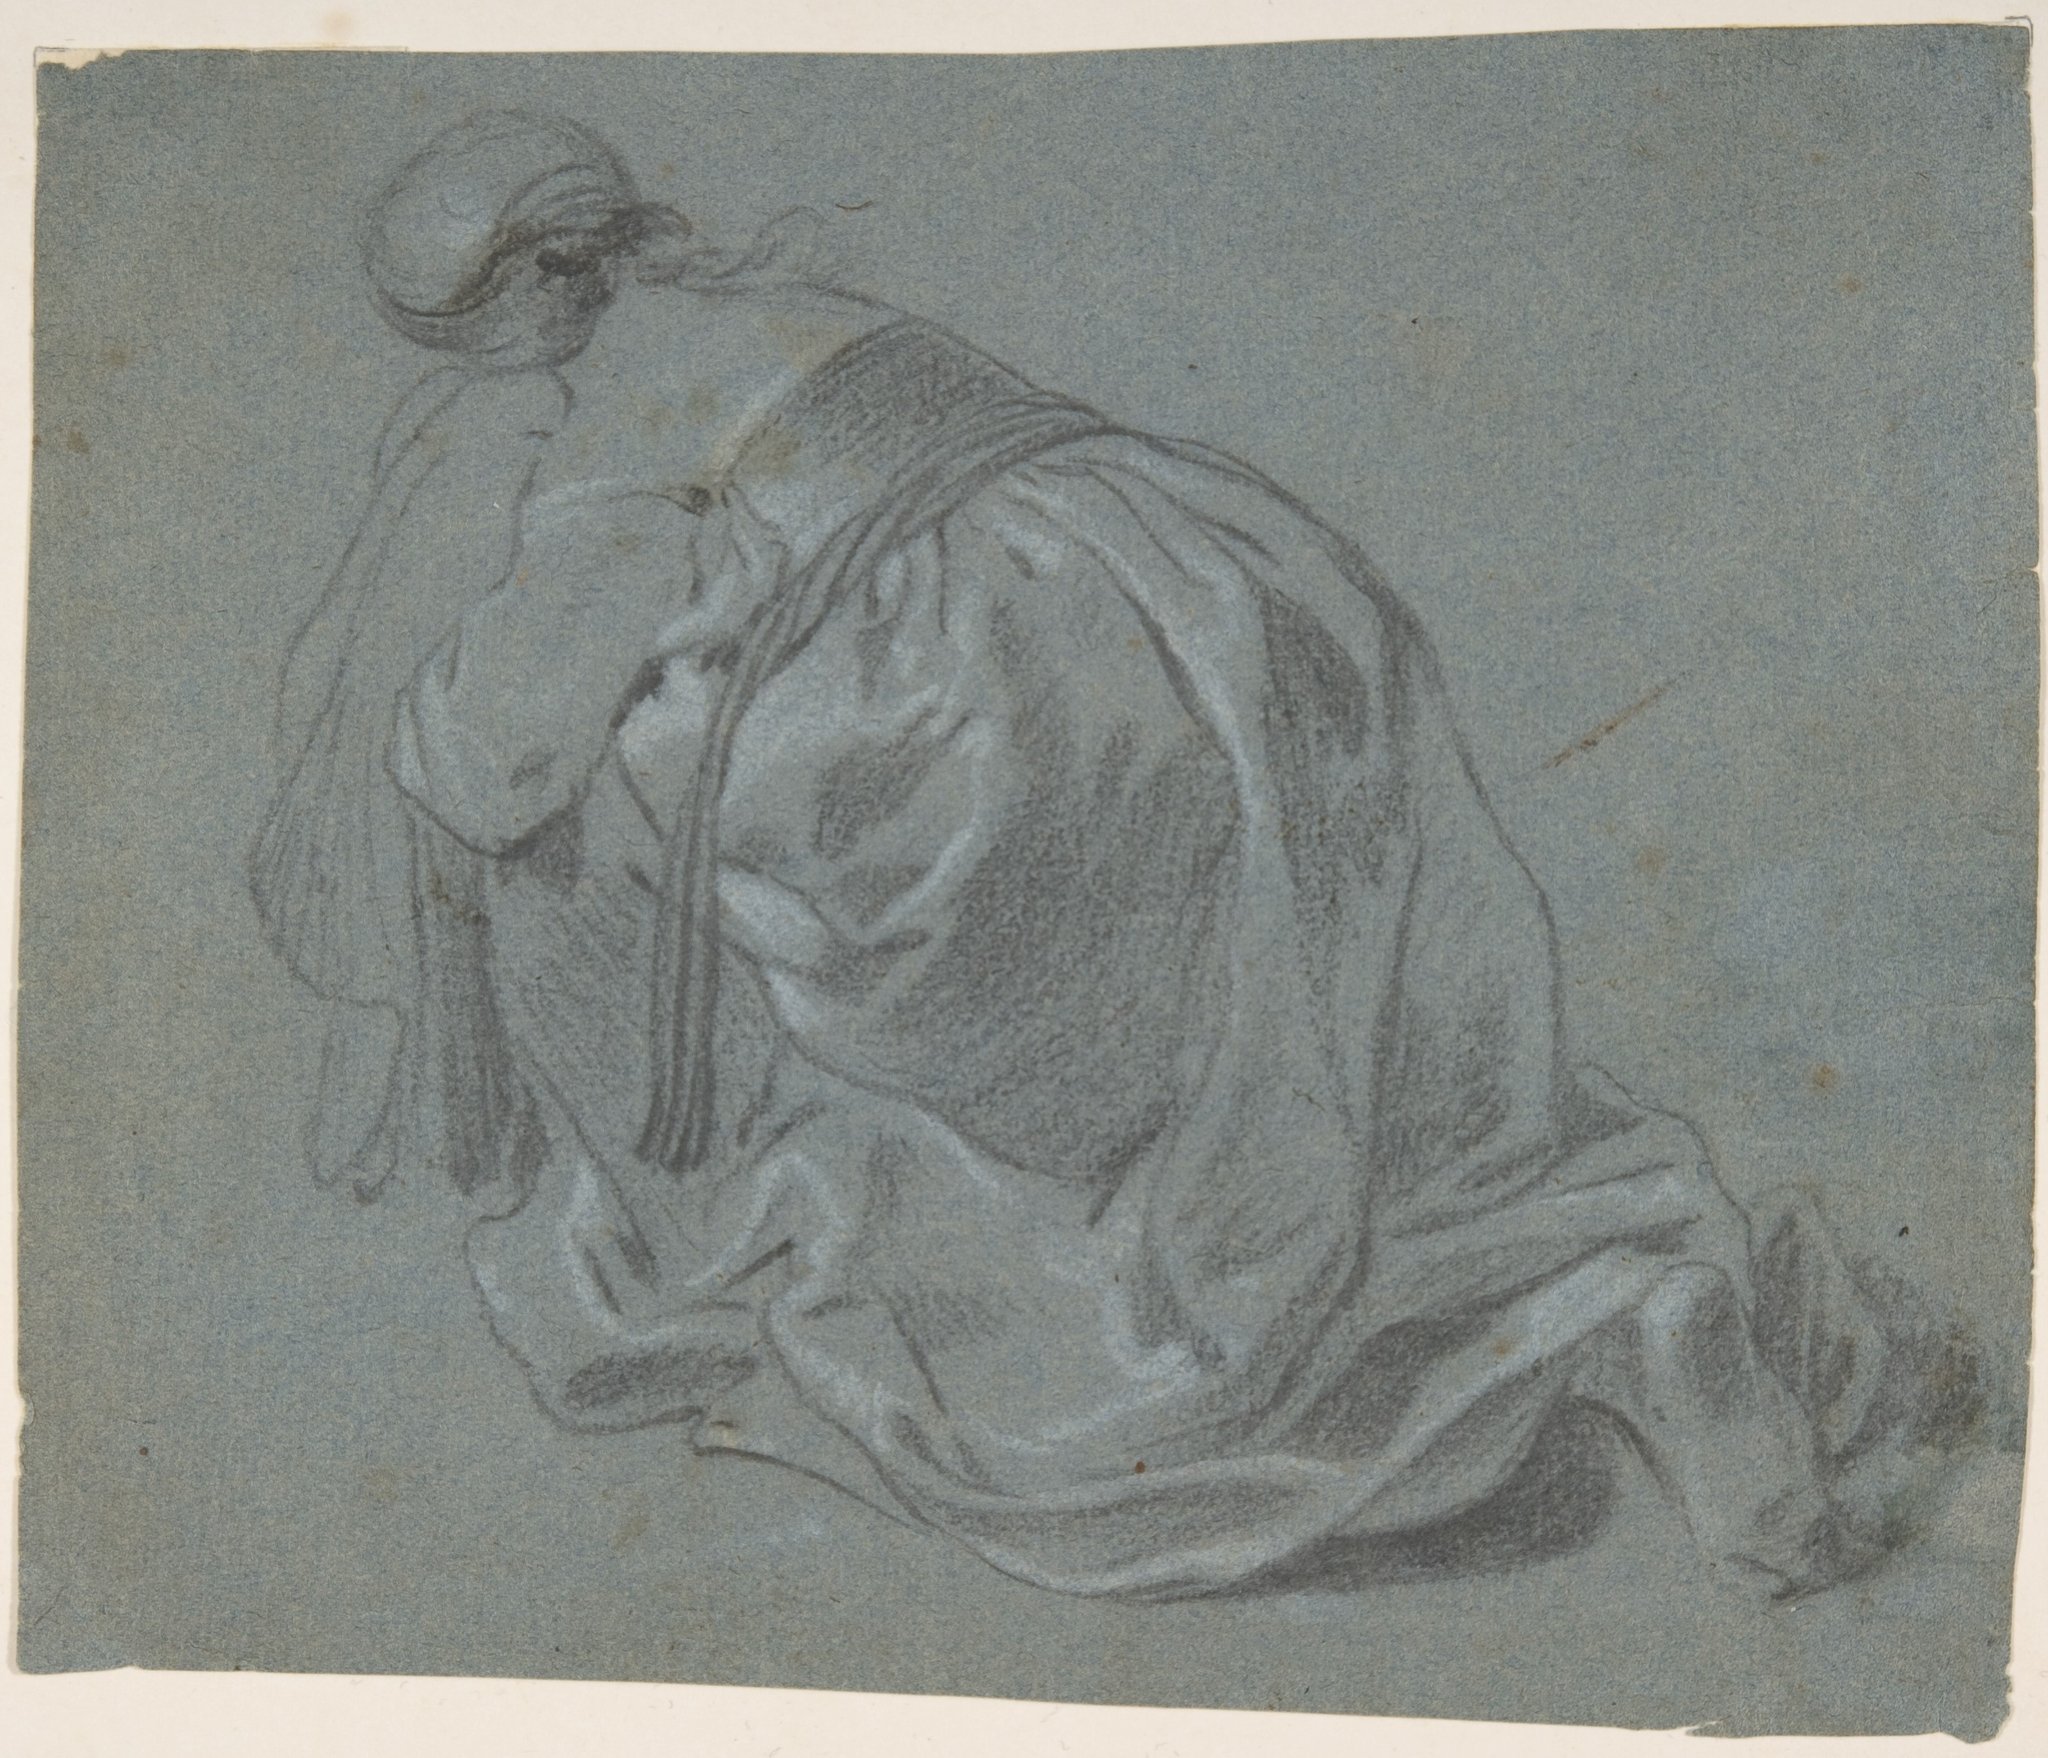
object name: drawing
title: Weeping Woman Kneeling, Seen from Behind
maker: jacob backer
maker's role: artist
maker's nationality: dutch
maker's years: 1608-1651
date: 1634-1638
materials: chalk, paper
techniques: heightening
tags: women